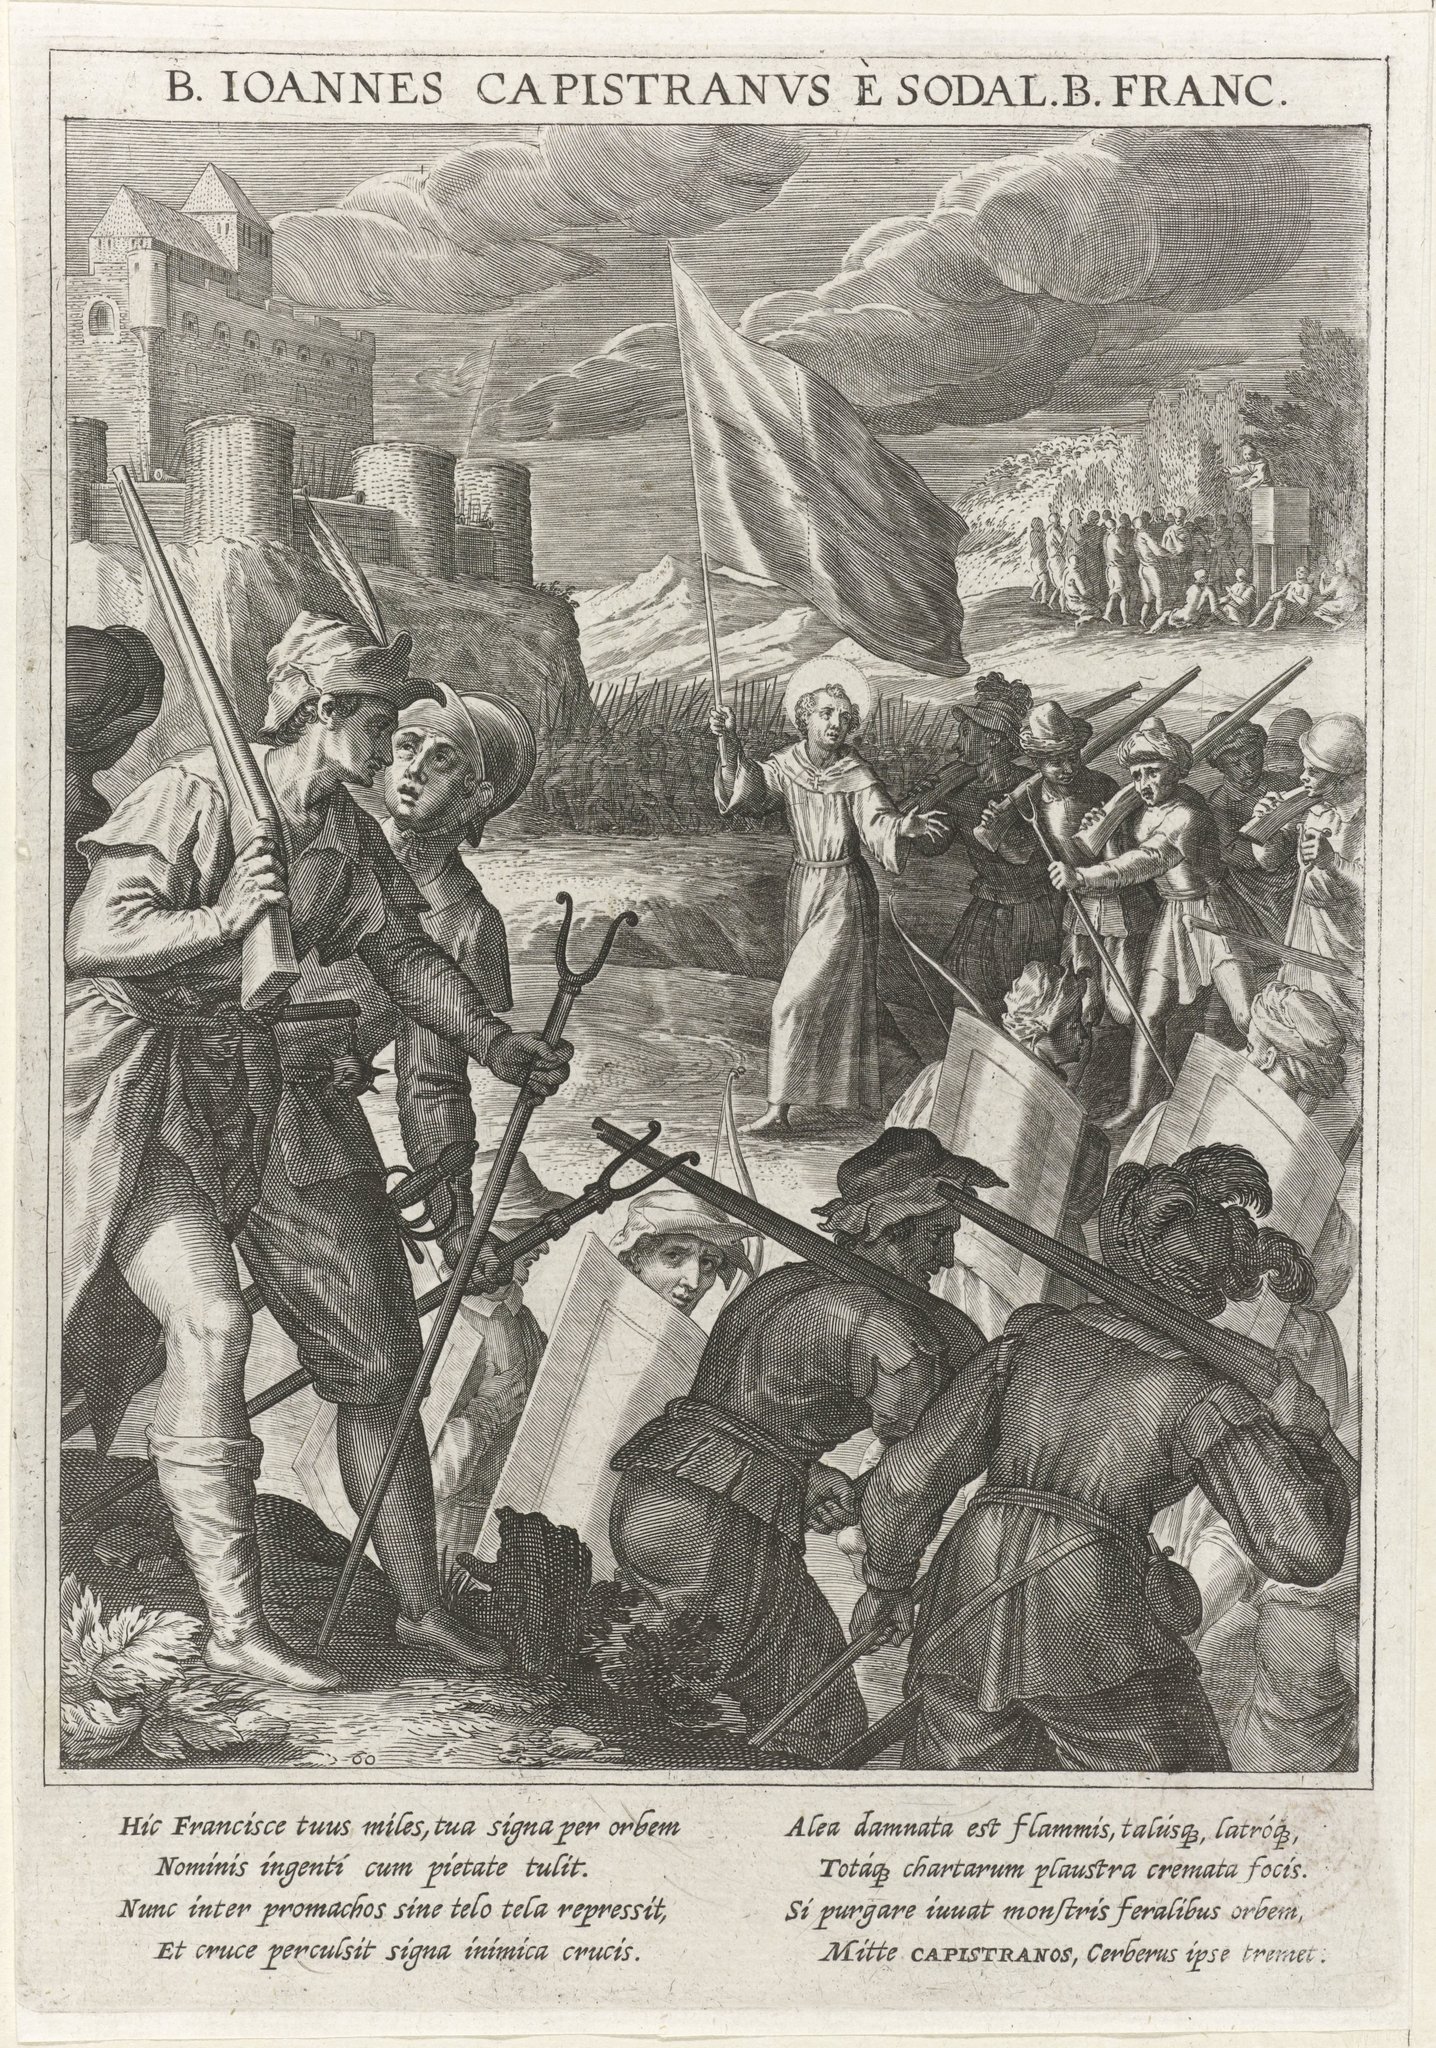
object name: print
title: B. Joannes Capistranvs è sodal. B. Franc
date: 1615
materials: paper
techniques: engraving, etching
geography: munich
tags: st. john of capestrano preaching against the vanities of this world; wordly goods are burned in public, st. john of capestrano fighting the turks in the battle of belgrado, militant proselytizing: religious war, crusade, etc., preaching (in general), siege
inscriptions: collector's mark: Lugt 240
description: De H. Johannes van Capestrano leidt met een kruisvaan in de hand de Hongaarse troepen naar de overwinning bij het beleg van Belgrado. Op de achtergrond preekt hij de kruistocht tegen de Ottomanen. De prent heeft een Latijns onderschrift en is de 60ste prent van een 60-delige serie met als onderwerp de heiligen van Beieren.